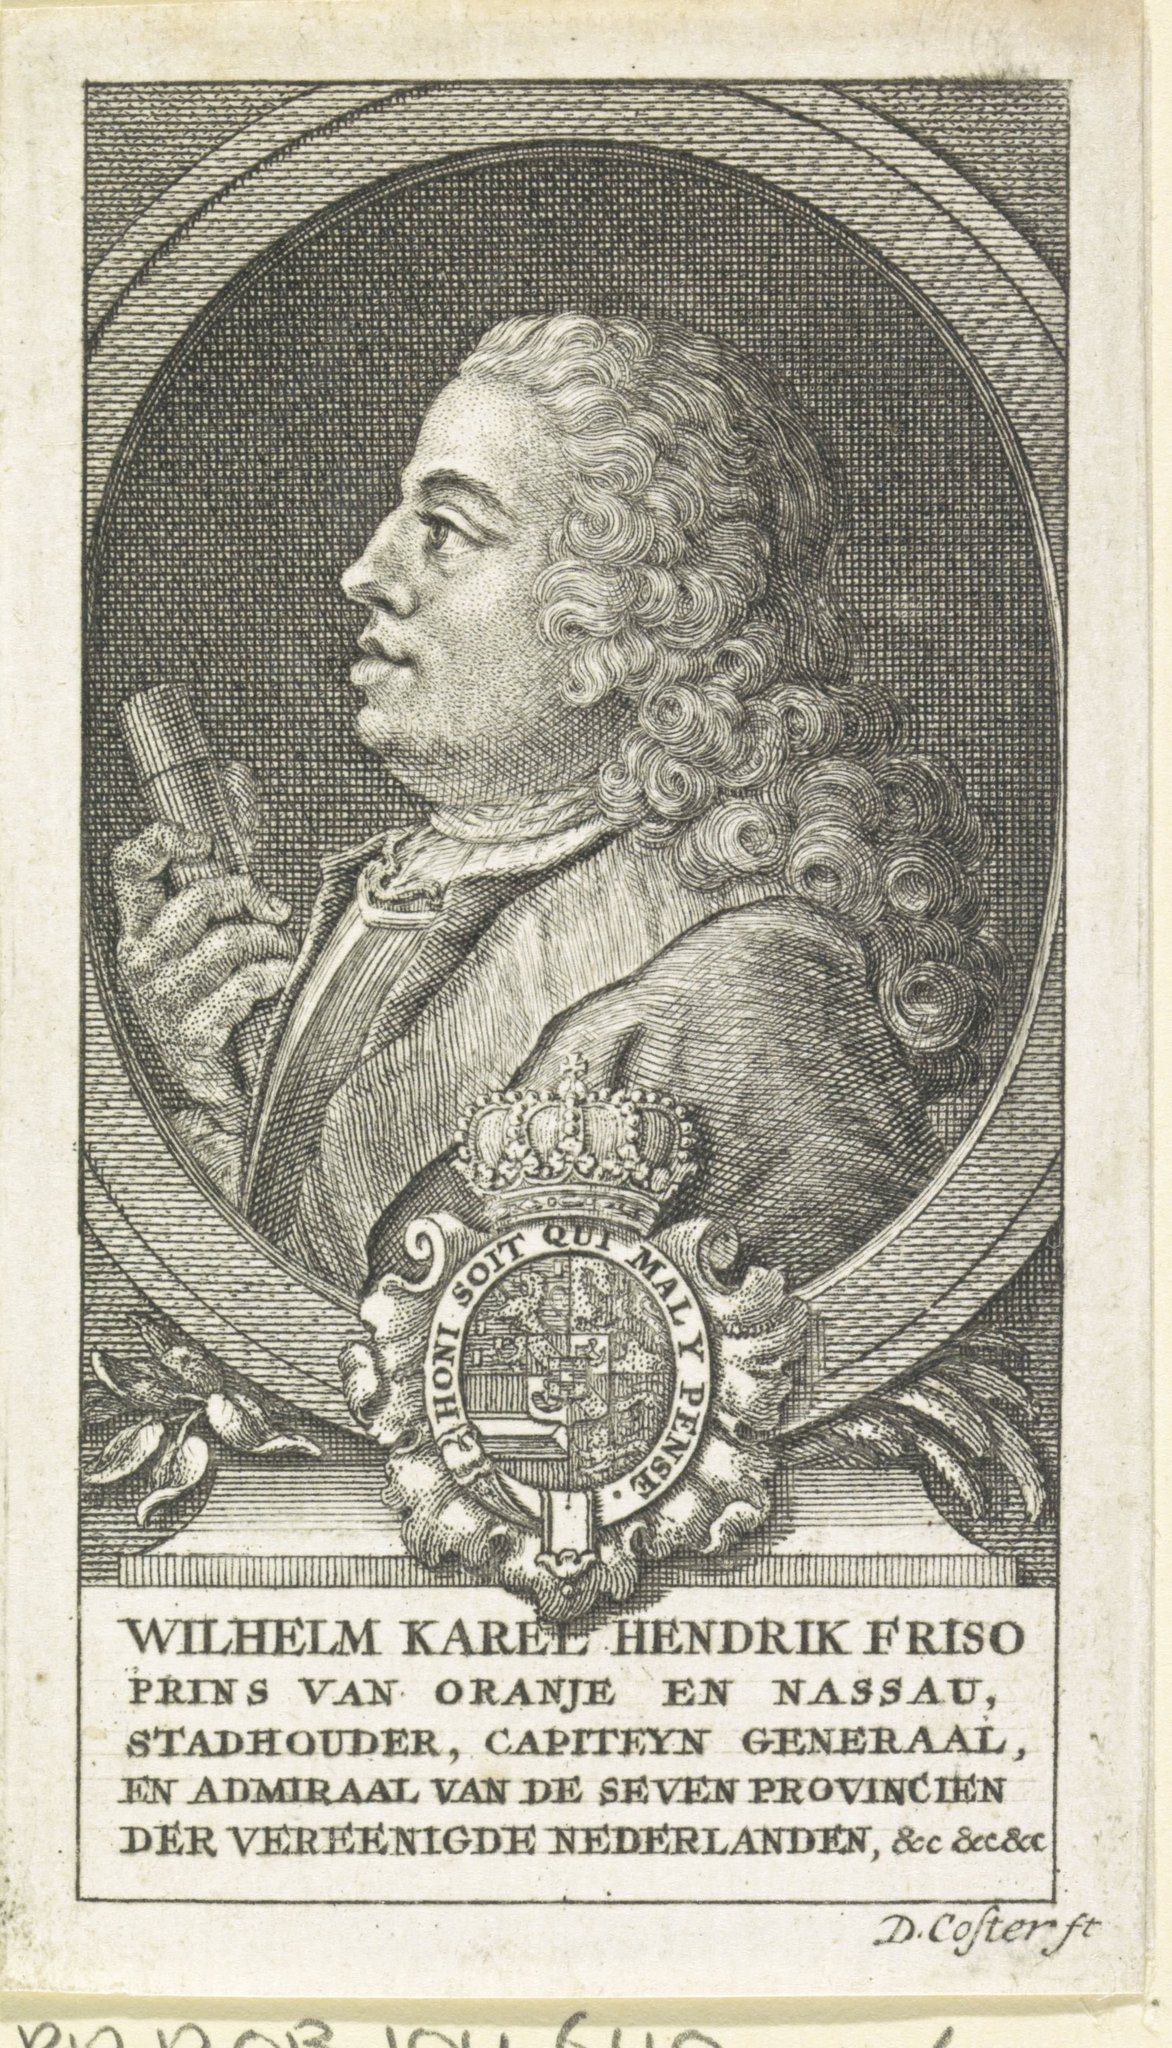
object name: print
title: Portret van Willem IV, prins van Oranje-Nassau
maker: david coster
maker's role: print maker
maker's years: 1676-1752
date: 1747-1752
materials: paper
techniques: engraving, etching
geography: the hague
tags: the hague, willem iv (prins van oranje-nassau), knighthood order (garter) - insignia of a knighthood order, e.g.: badge, chain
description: Portret van Willem IV in een ovaal. In zijn rechterhand een commandostaf. Midden onder zijn wapen met een kroon, gedecoreerd met de Kousenband en het devies van de Orde van de Kousenband. In een kader zijn naam en titels.